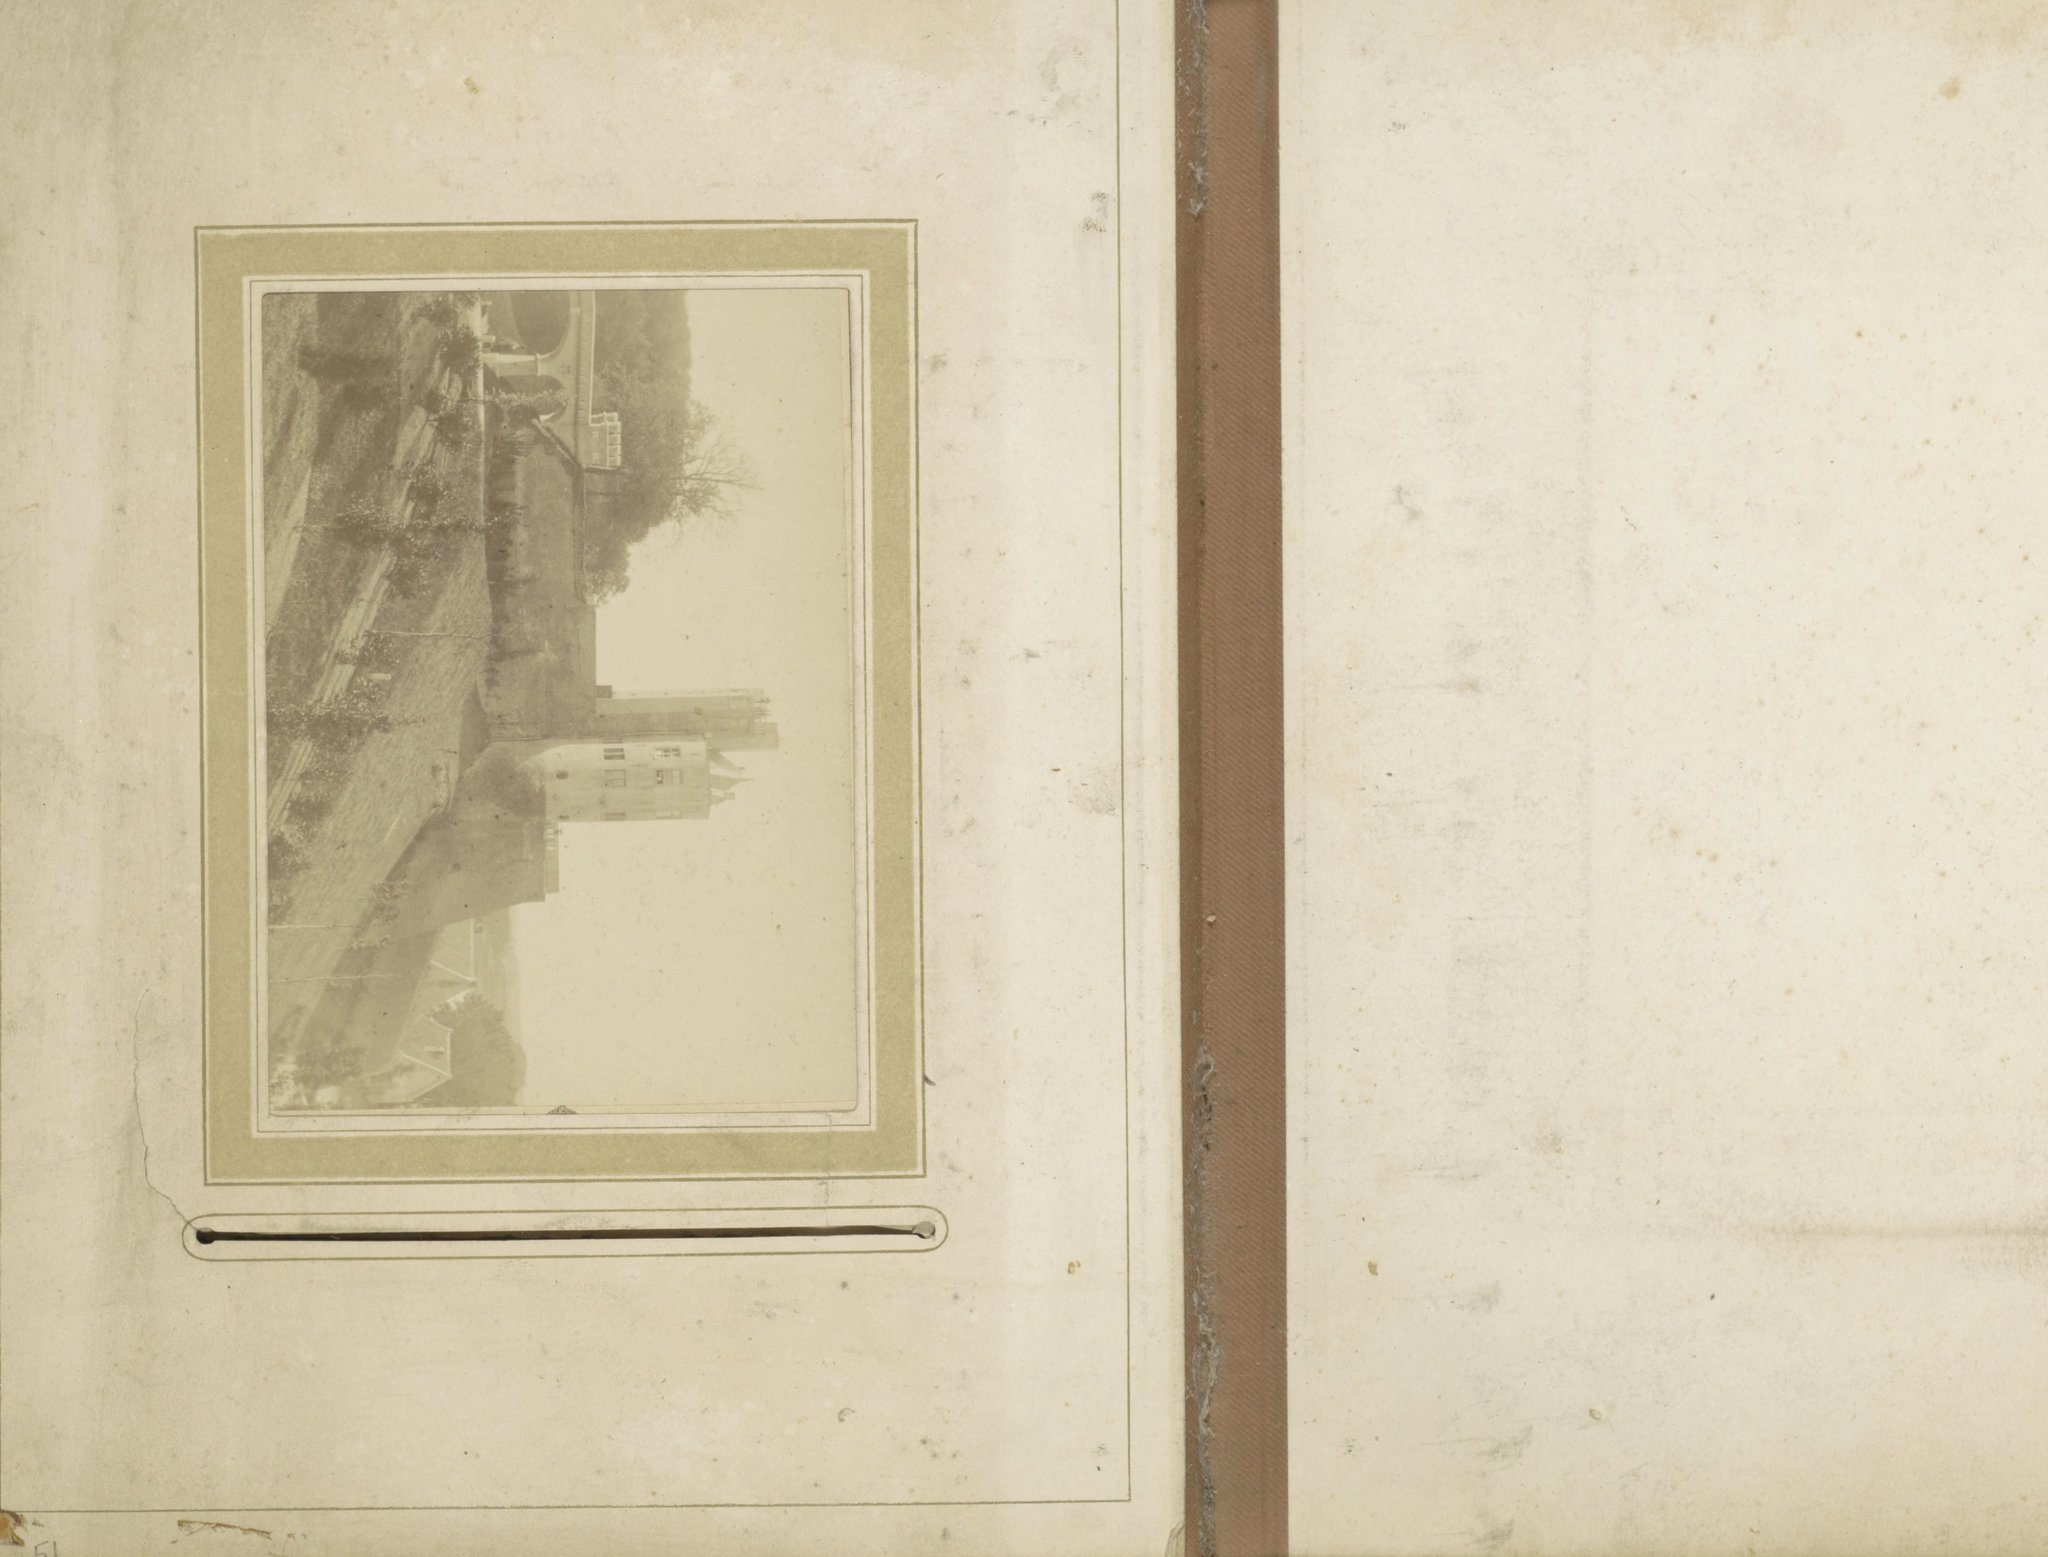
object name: cabinet photograph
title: Torens en een voetbrug van de Belvédère van Nijmegen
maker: wilhelm ivens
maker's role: fotograaf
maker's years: 1849-1904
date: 1870-1900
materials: cardboard, paper, photographic support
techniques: albumen print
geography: nijmegen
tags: fortress, towers ~ fortified city, landscape with bridge, viaduct or aqueduct, public gardens, park, nijmegen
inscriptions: address: ‘Nijmegen’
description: Onderdeel van Fotoalbum van een Nederlandse familie met 168 cartes-de-visite en kabinetfoto's.